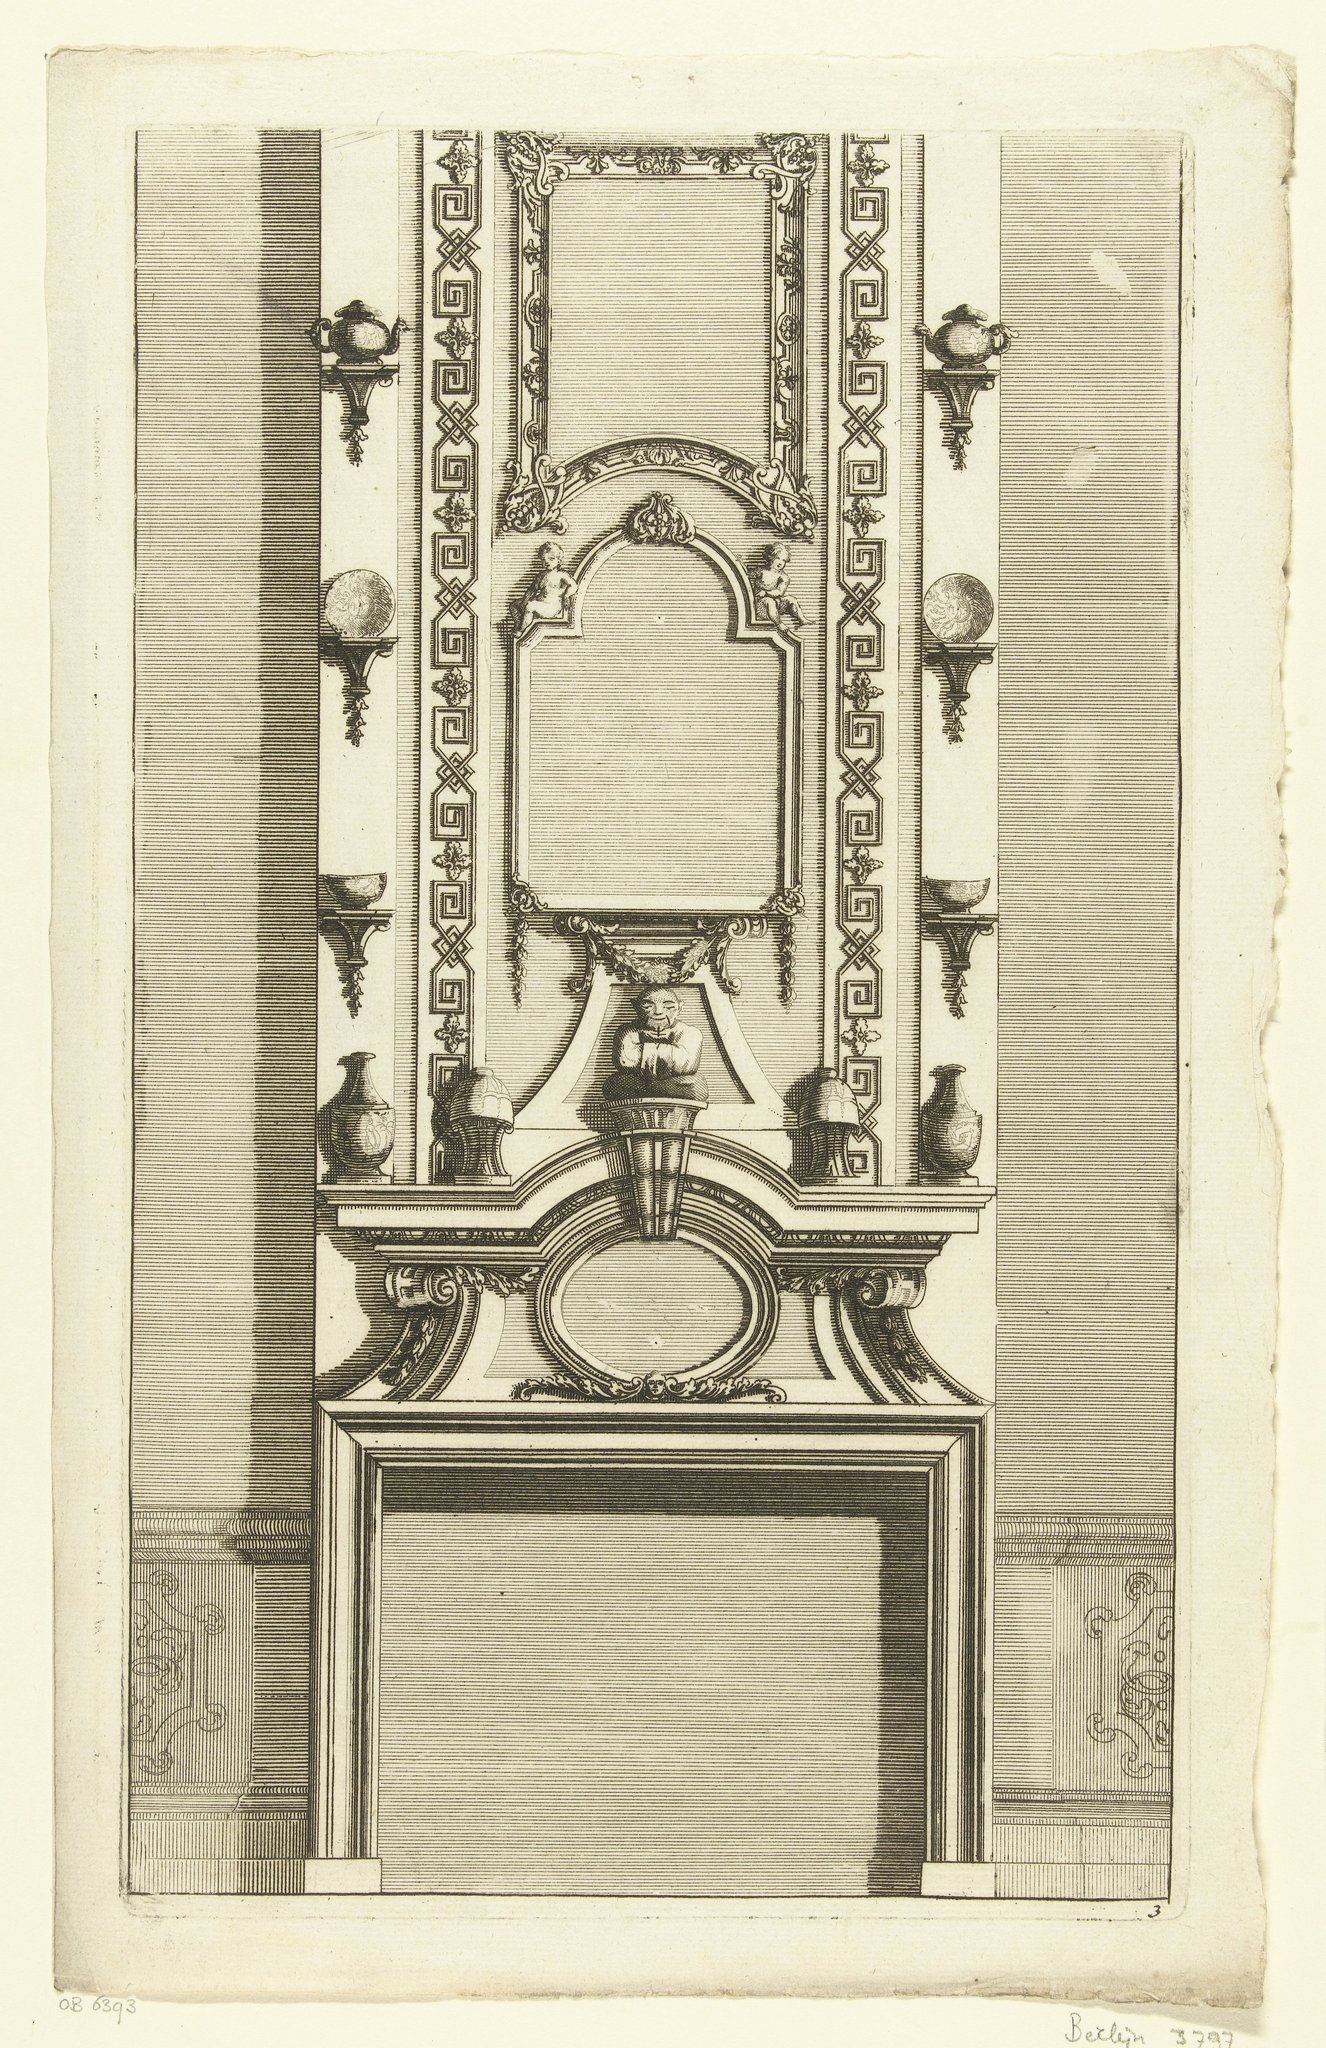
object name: ornament print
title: Schoorsteenmantel met drie spiegels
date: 1680-1700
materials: paper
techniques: etching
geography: amsterdam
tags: mirror, chimney-piece, mantelpiece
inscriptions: number: ‘3’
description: Schoorsteenmantel met een gedeeltelijk gebogen tablet boven een ovale spiegel. Op het tablet staan, aan weerszijden van een Chinees beeld, twee Chinese vazen. Daarboven hangen twee spiegellijsten. Aan de zijkanten hangen drie consoles met Chinees porselein.